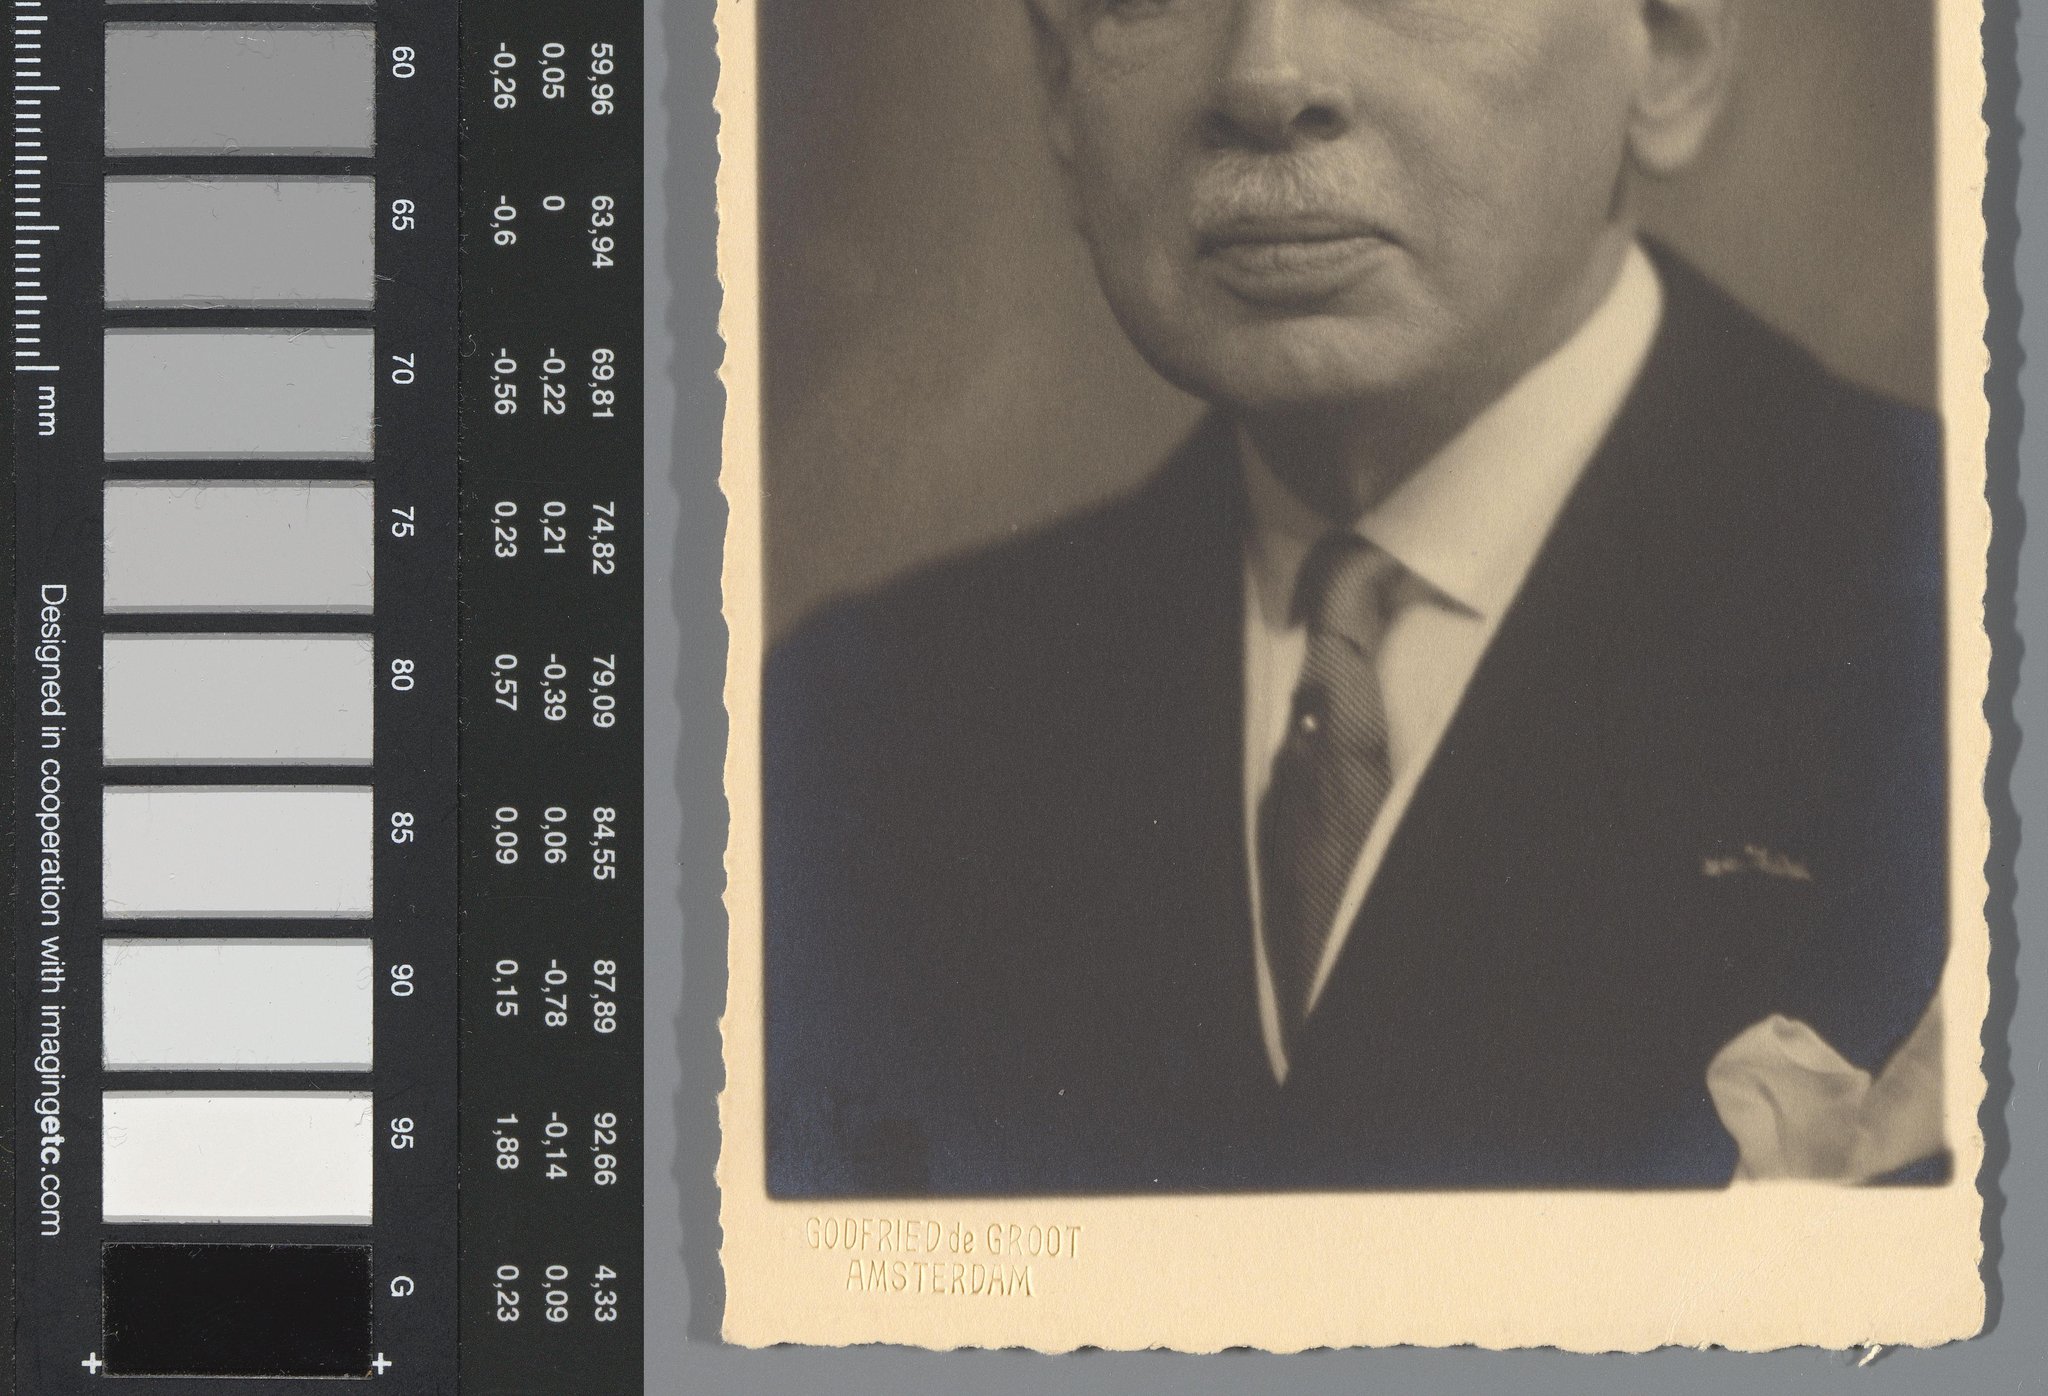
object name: photograph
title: Portret van Karel Frederik van den Berg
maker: godfried de groot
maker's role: fotograaf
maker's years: 1894-1963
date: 1930-1945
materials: photographic support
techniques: photography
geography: amsterdam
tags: batavia, karel frederik van den berg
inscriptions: name: ‘Godfried de Groot / Moderne Portretfotografie / Jan Luykenstraat 2a Amsterdam / Telefoon 28474’, name: ‘Karel’, name: ‘GODFRIED de GROOT / AMSTERDAM’